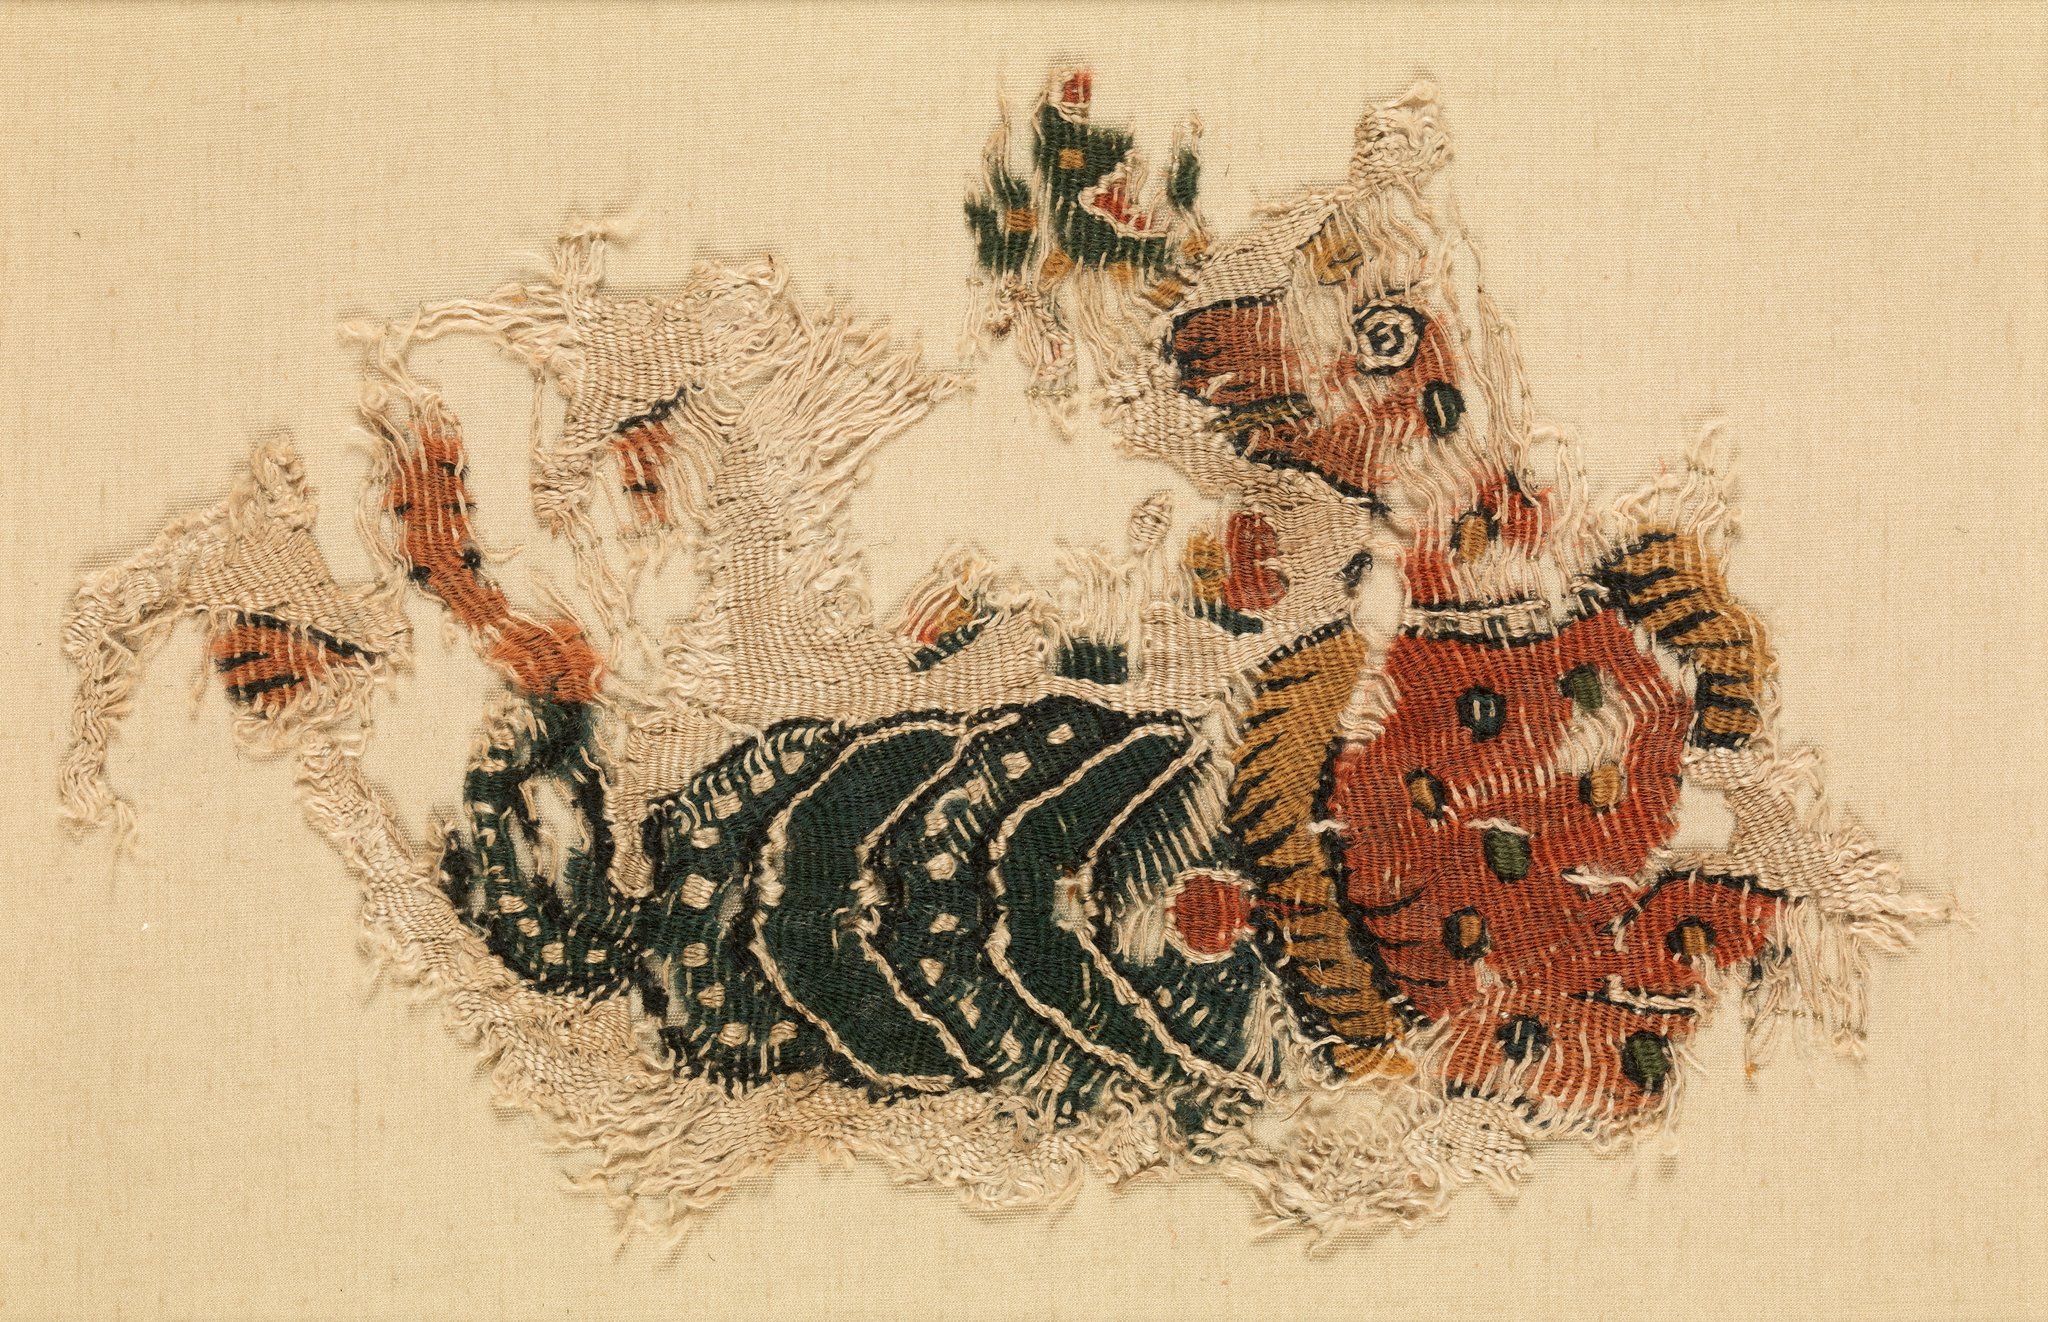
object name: textile fragment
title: Textile Fragment with Scorpion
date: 801-900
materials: linen, wool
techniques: tapestry, weave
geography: egypt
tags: scorpions